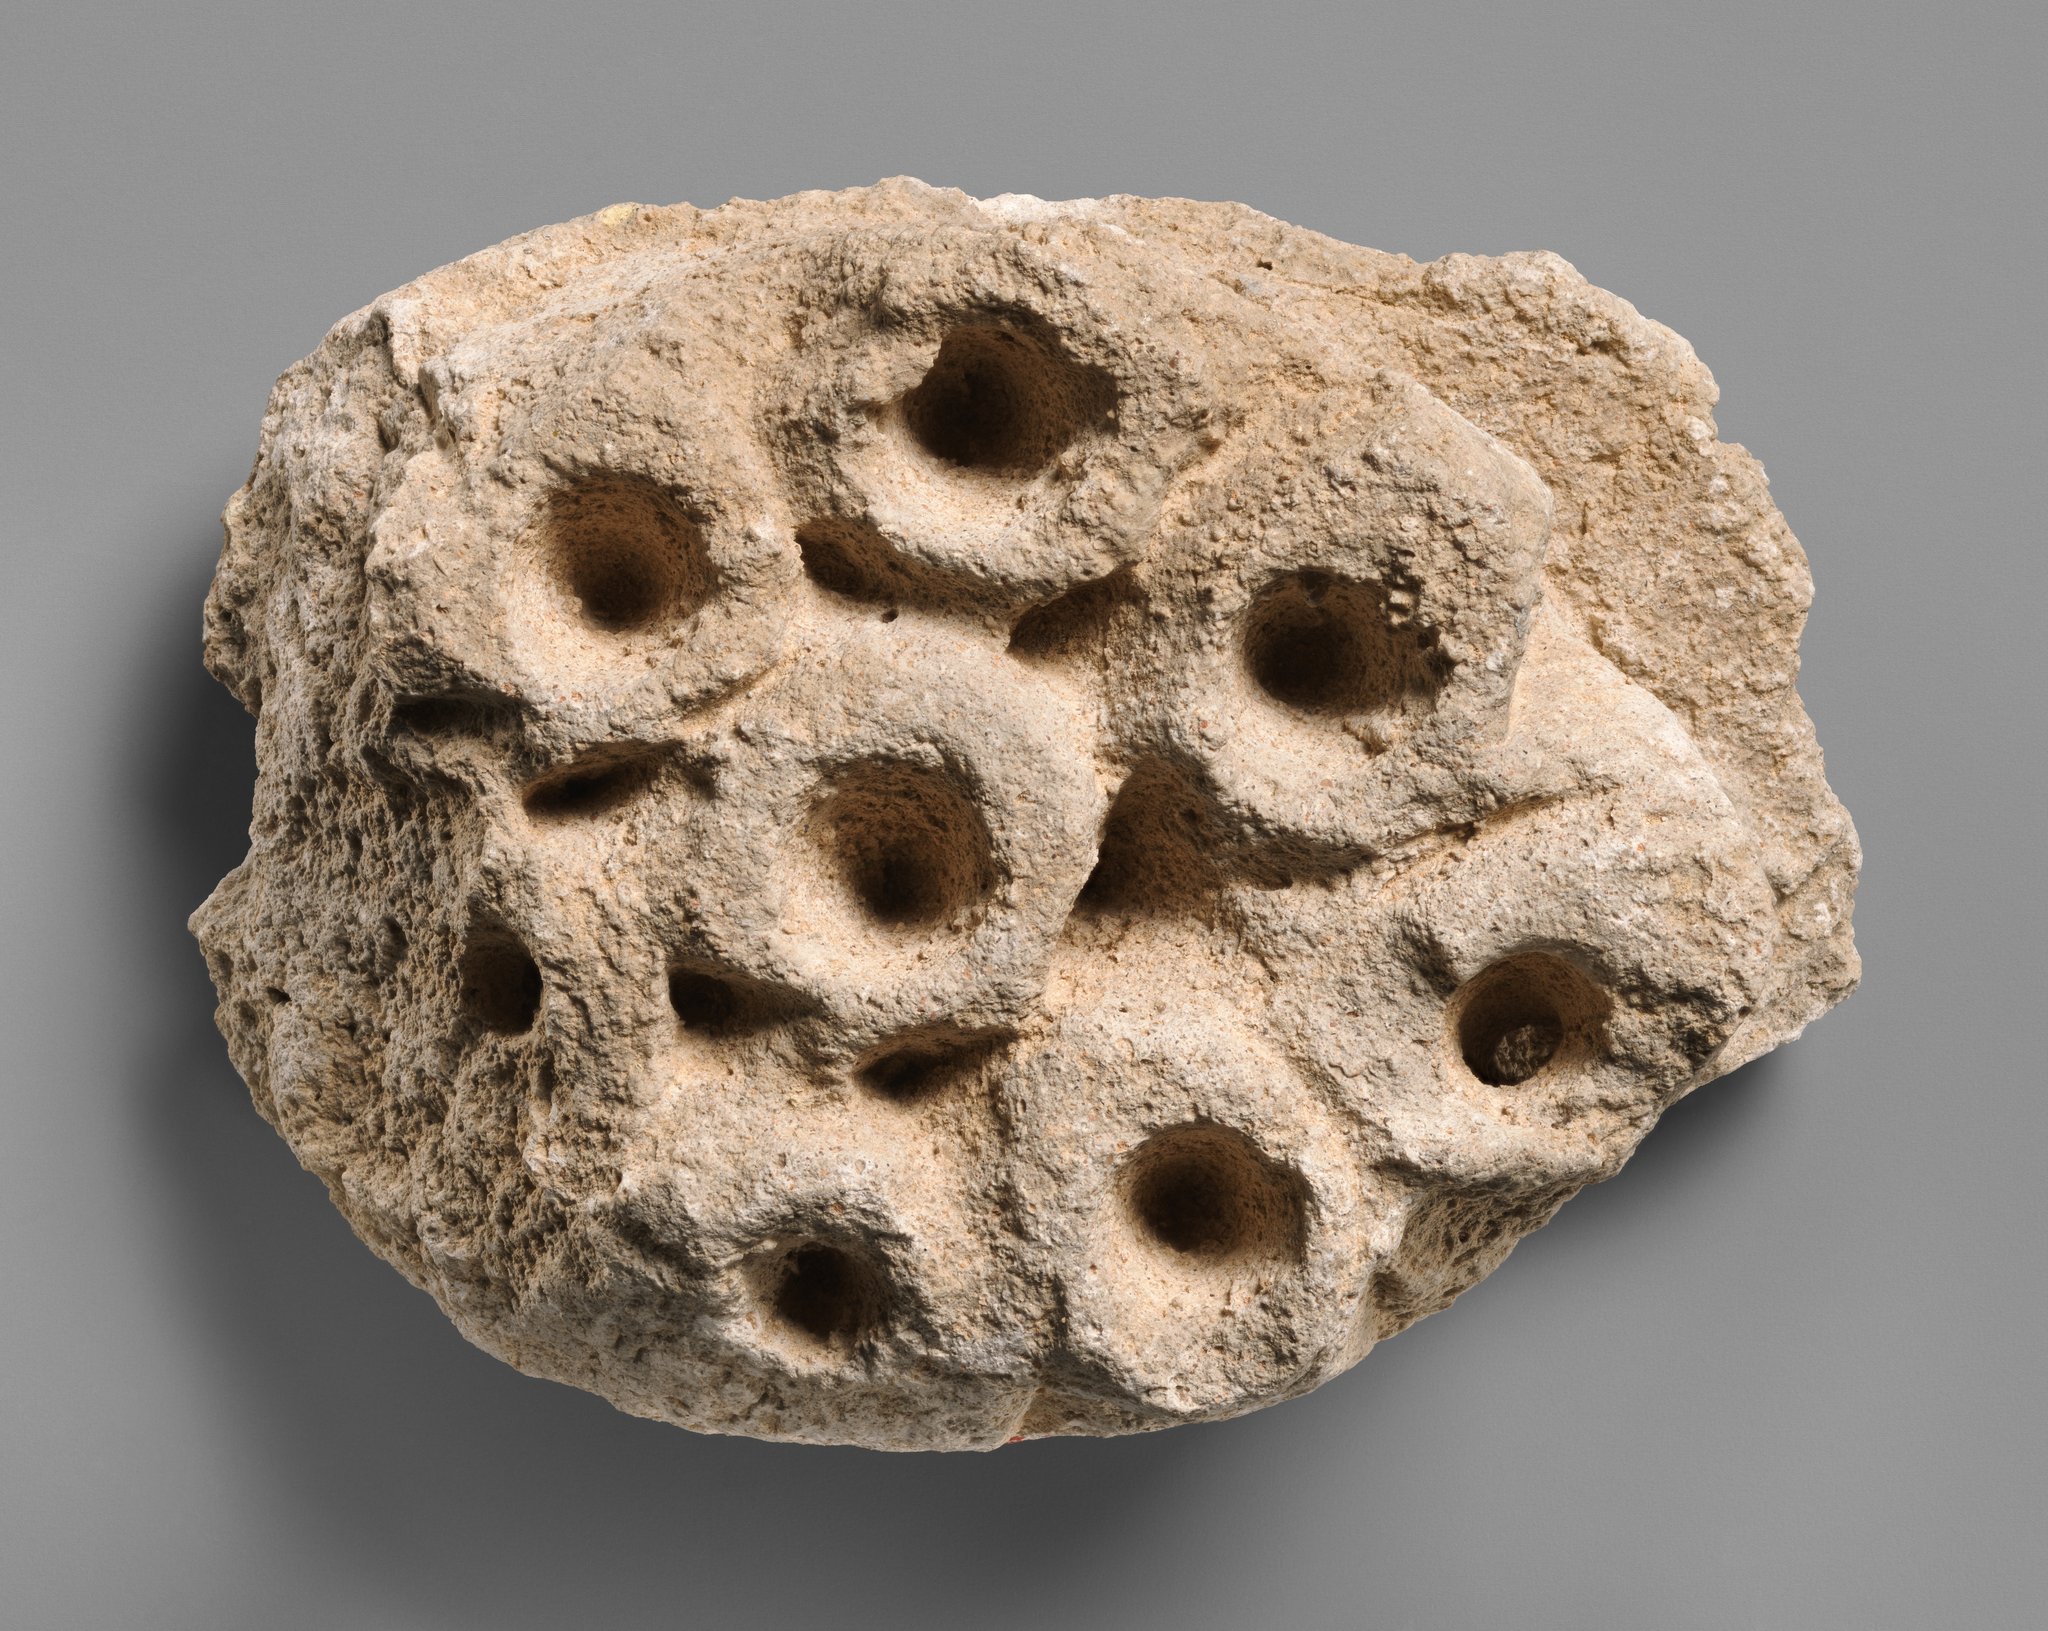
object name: relief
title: Relief fragment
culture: sasanian or islamic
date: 501-800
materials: plaster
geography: mesopotamia